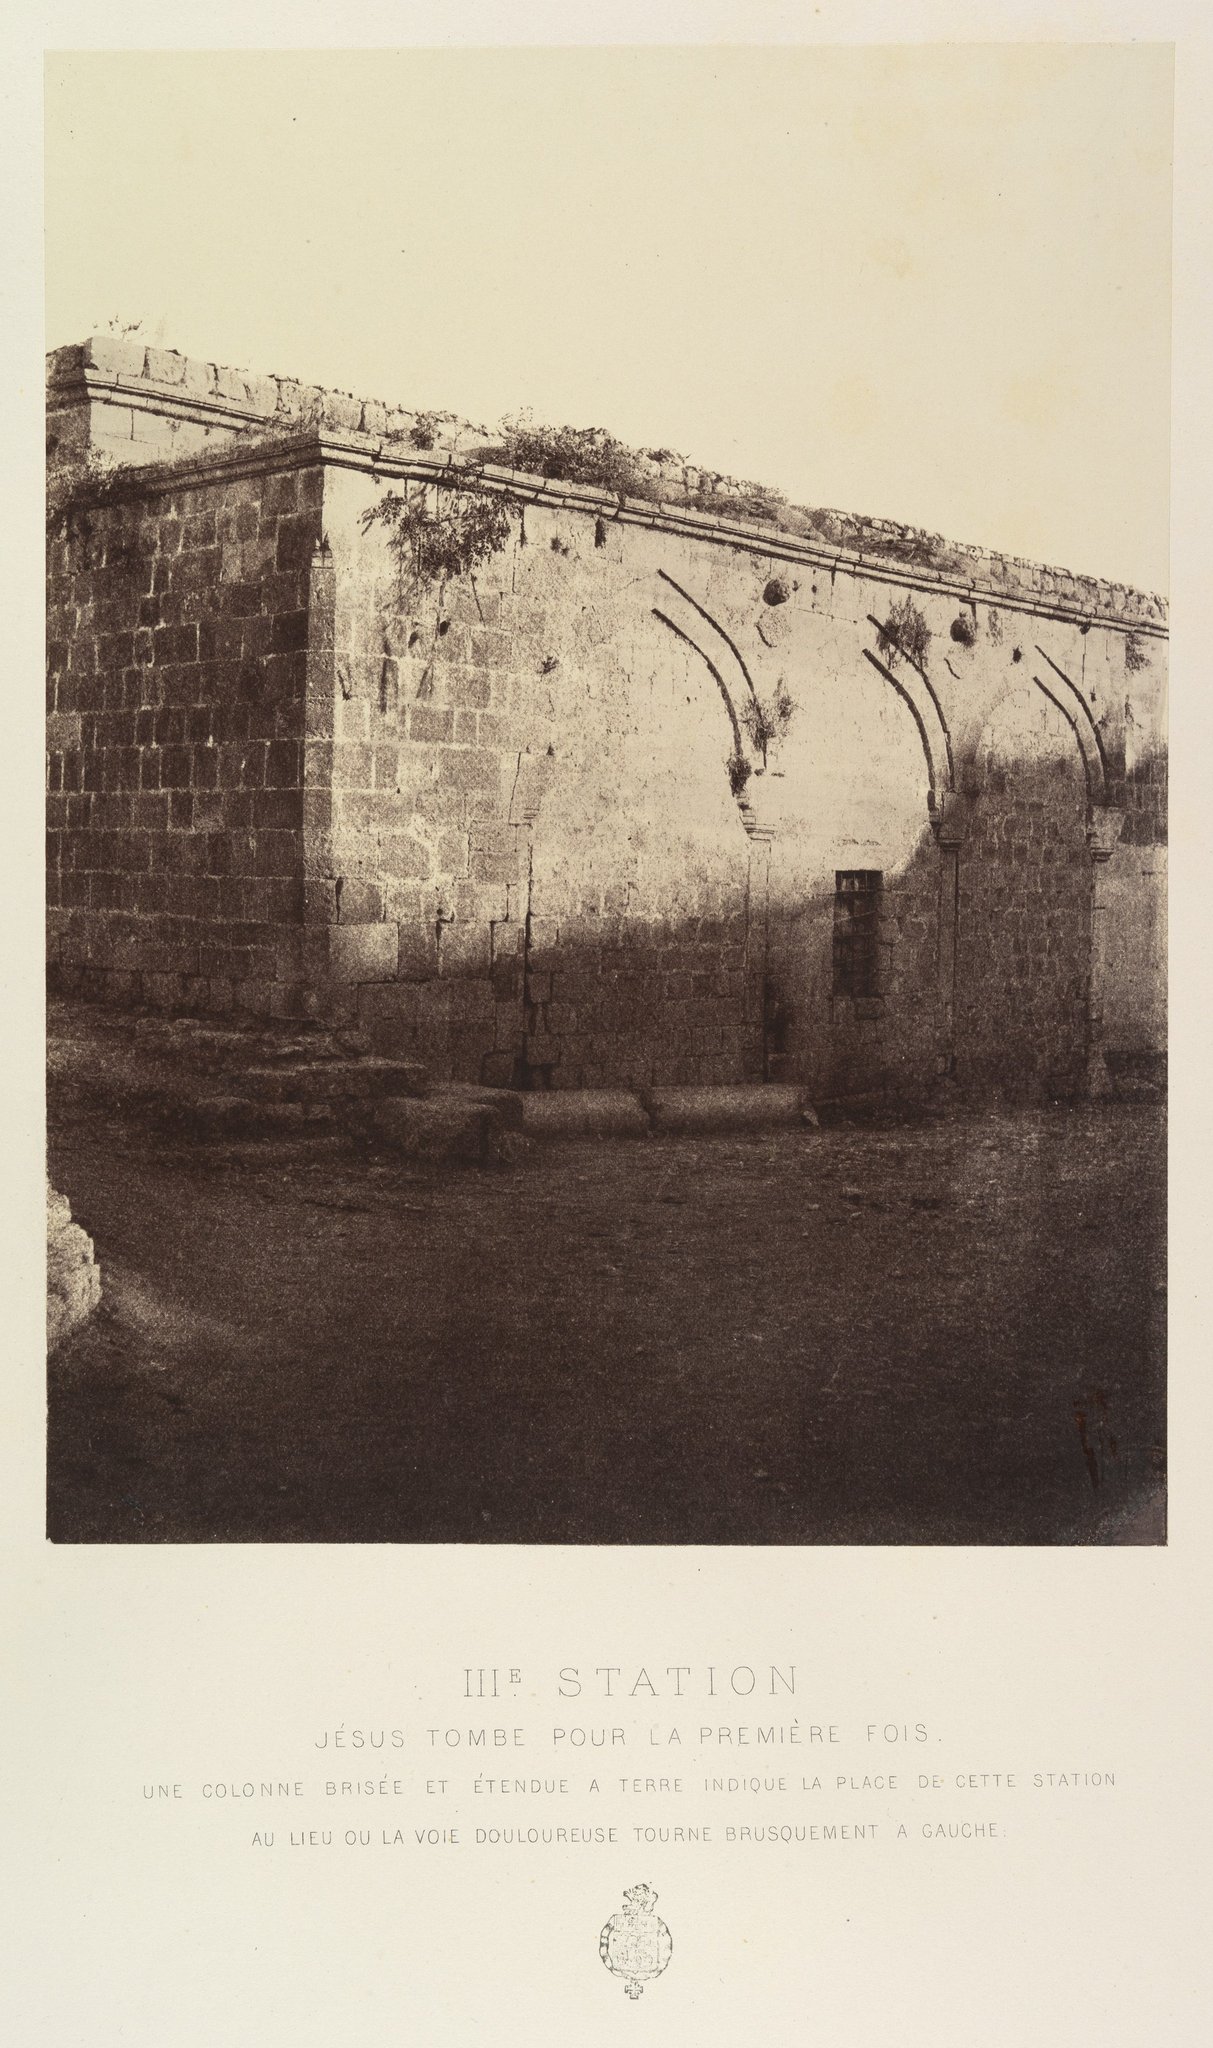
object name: photograph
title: IIIe Station. Jésus tombe pour la première fois. Une colonne brisée et entendue a terre indique la place de cette station au lieu où la voie douloureuse tourne brusquement a gauche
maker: louis de clercq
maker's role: artist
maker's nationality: french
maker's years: 1837-1901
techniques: albumen silver print, paper negative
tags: architecture,buildings